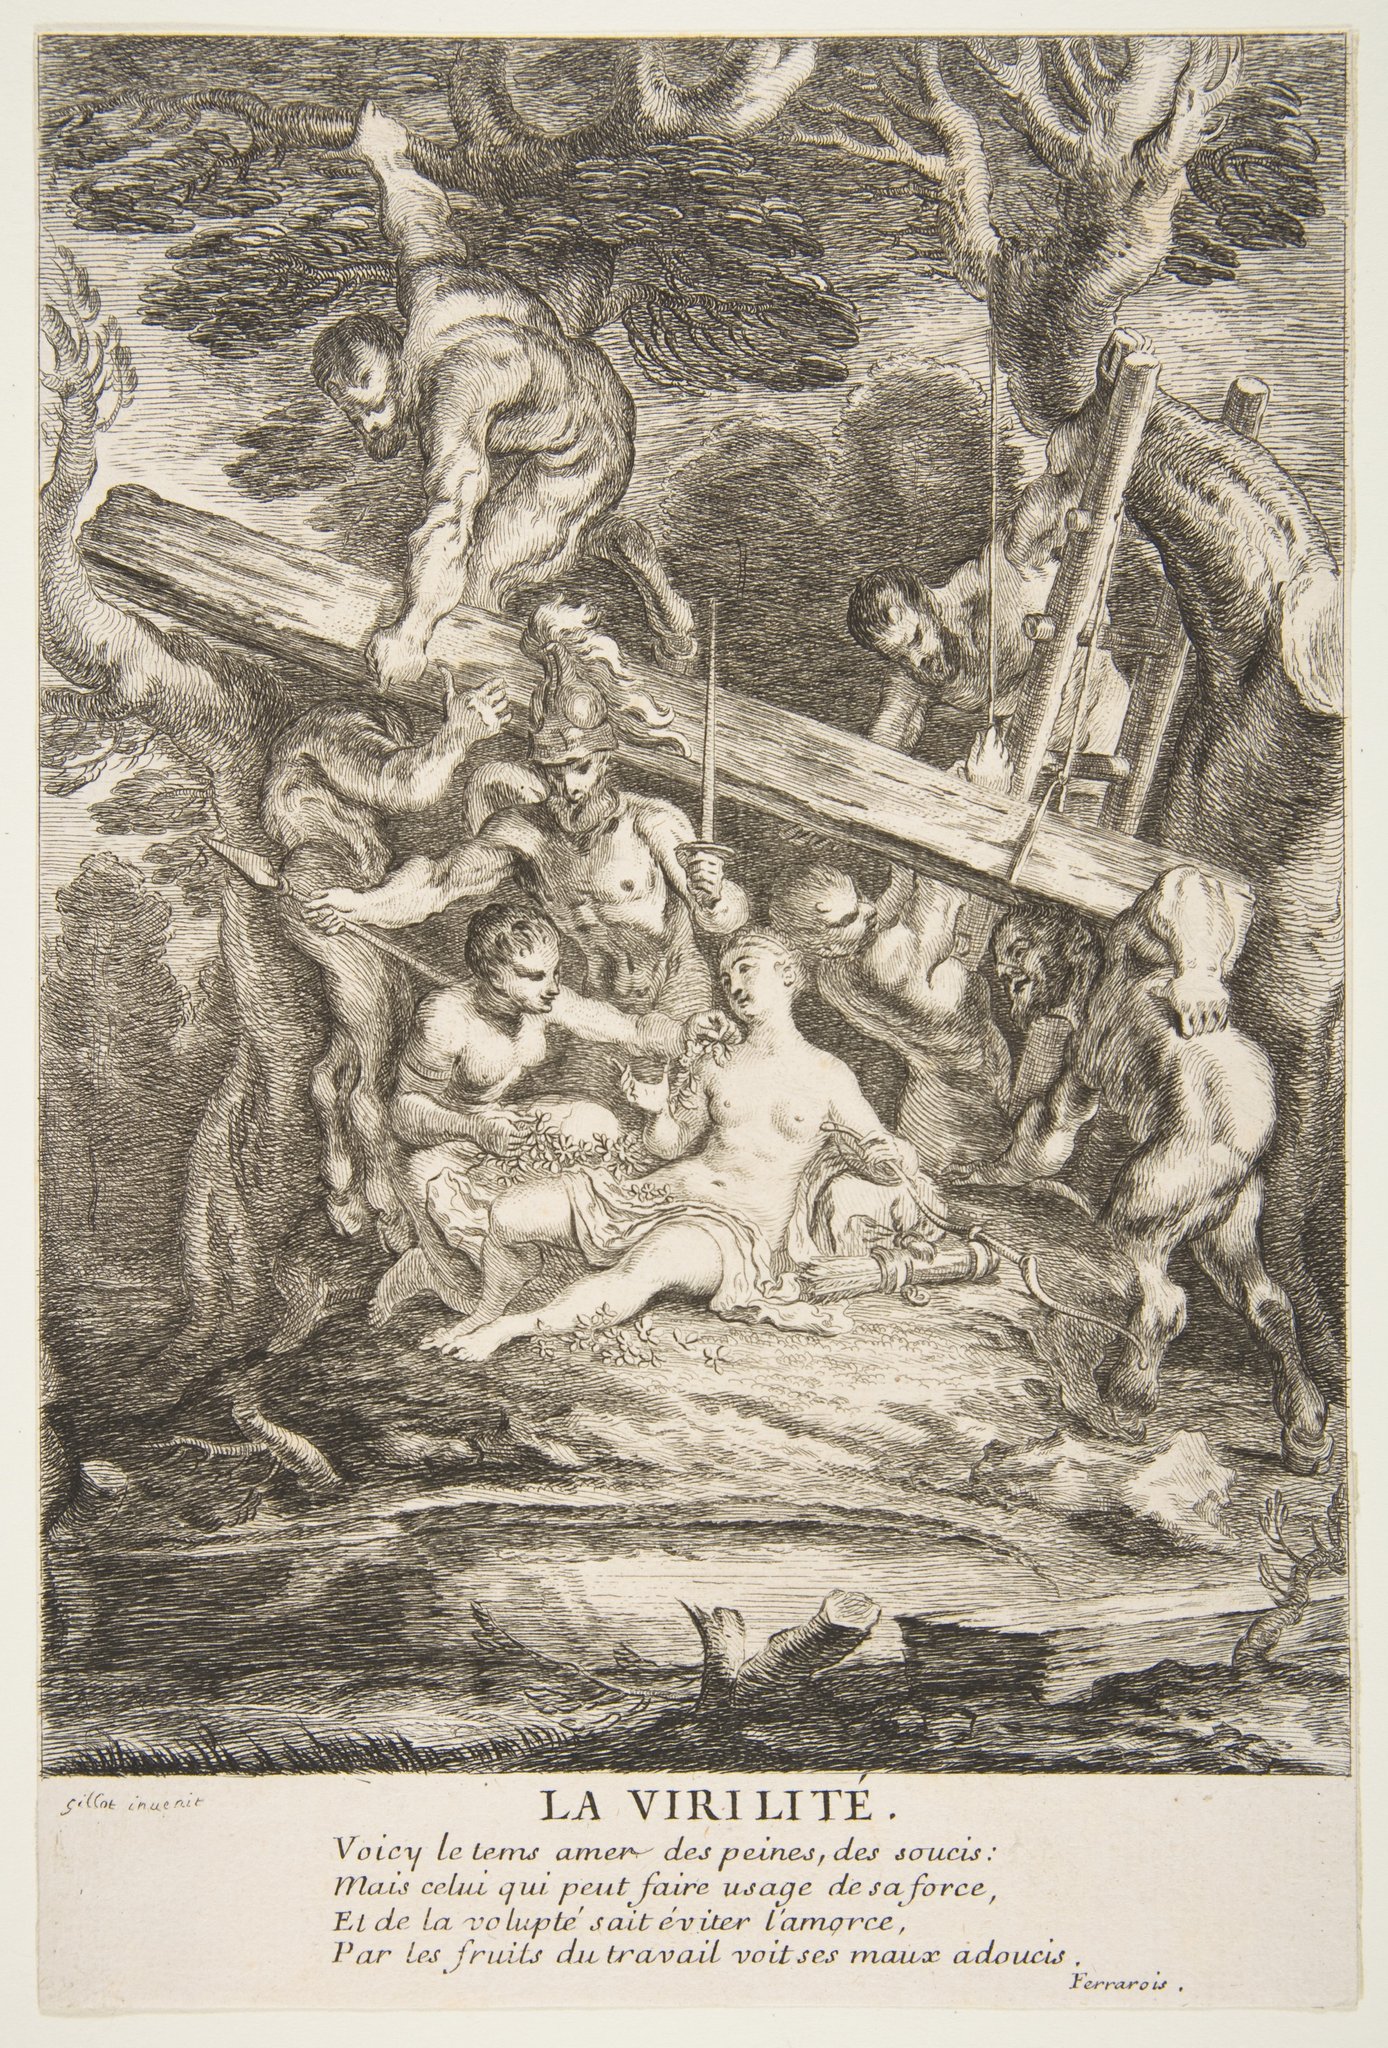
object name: print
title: Manhood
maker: claude gillot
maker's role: artist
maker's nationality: french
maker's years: 1673-1722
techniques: etching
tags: male nudes,female nudes,working